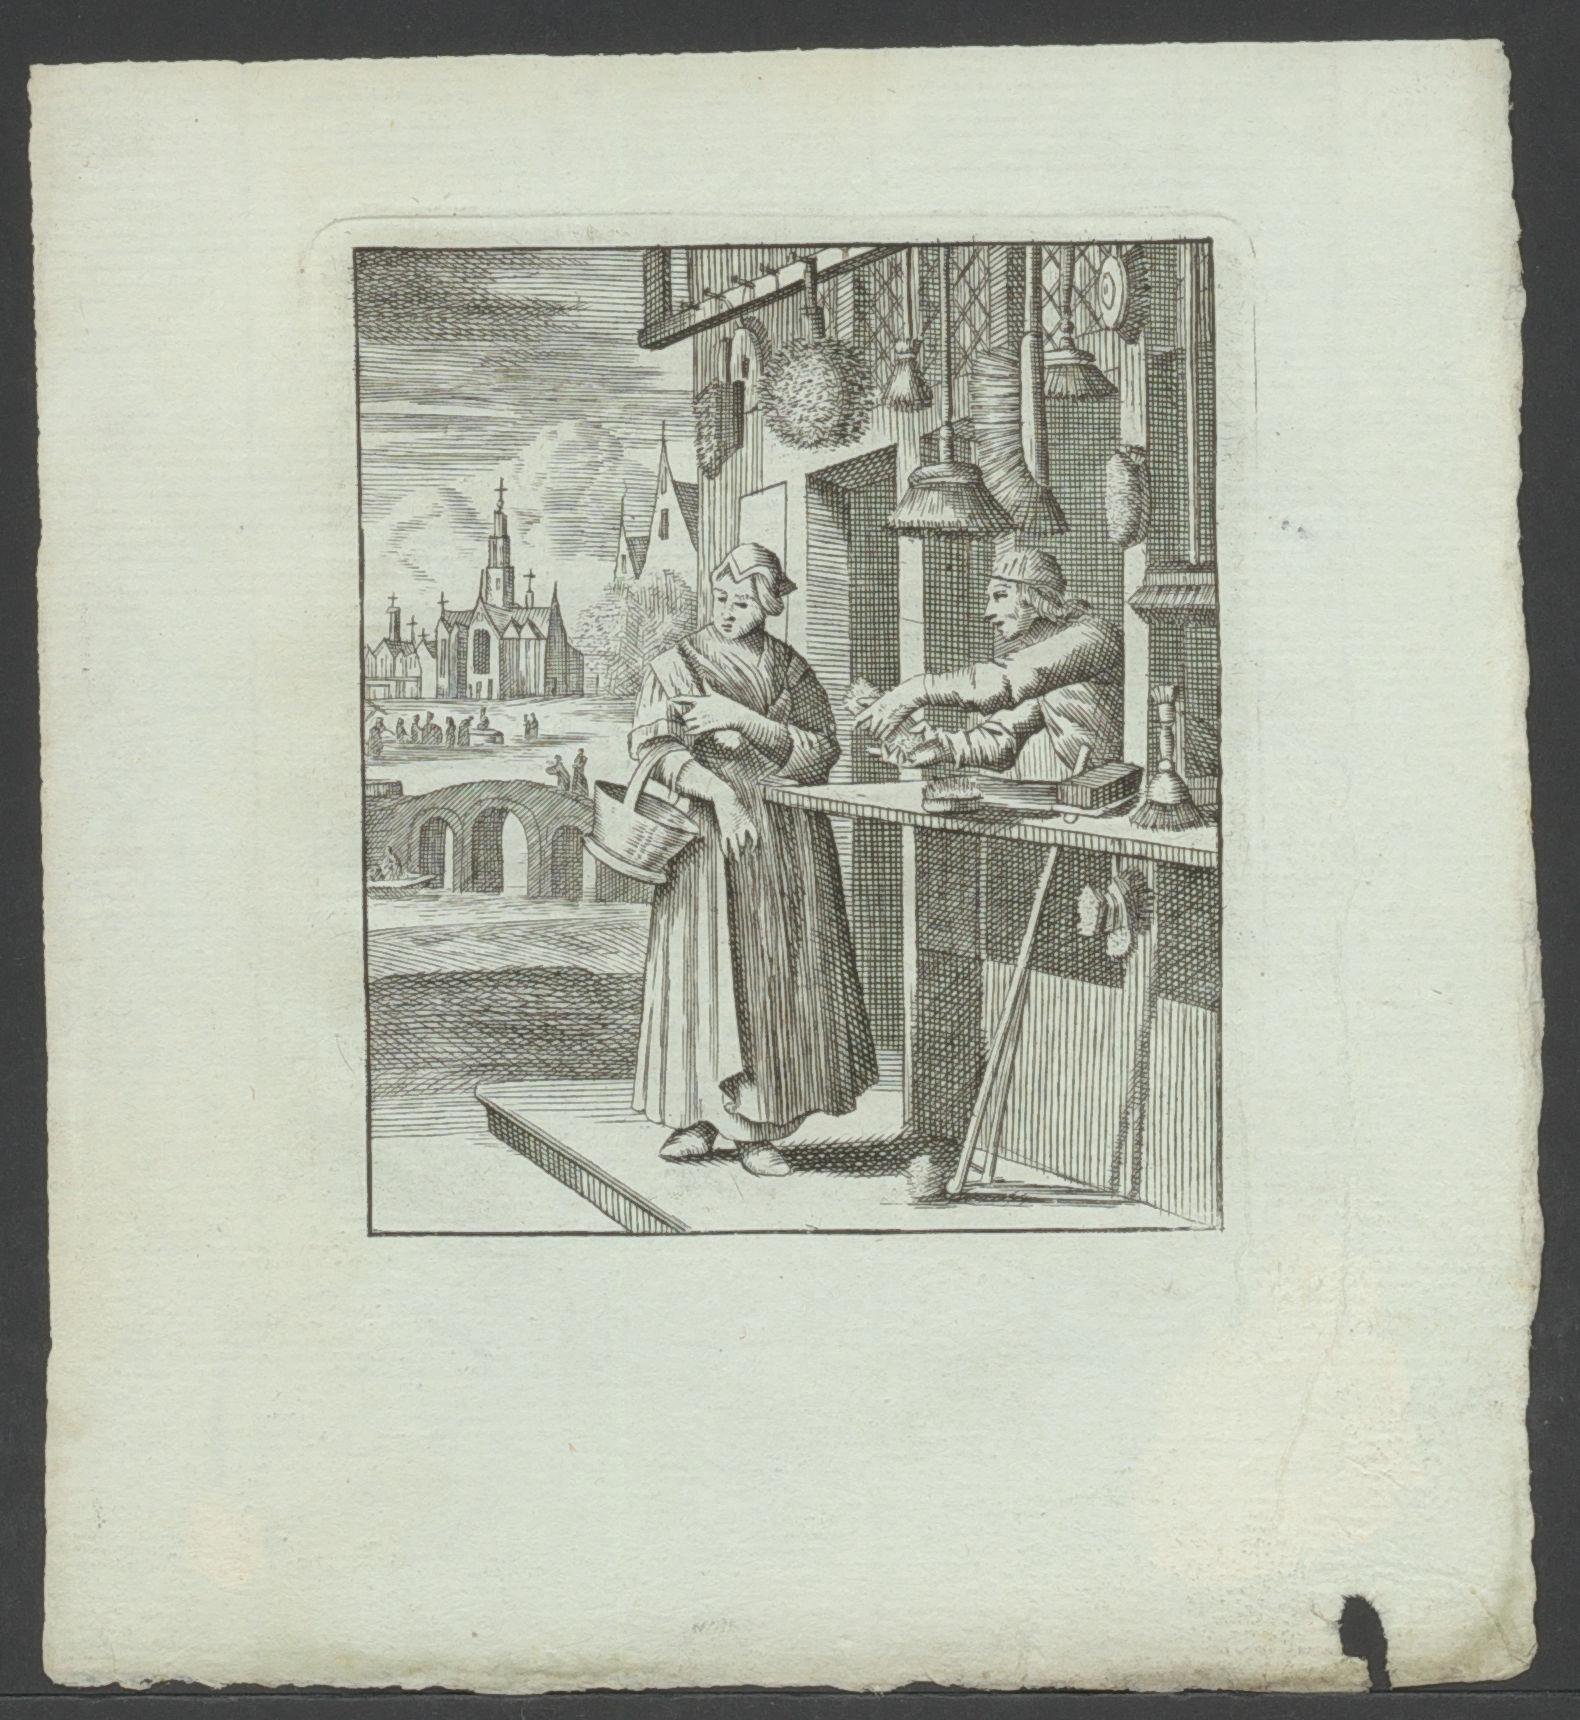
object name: print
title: Borstelmaker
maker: Anonymous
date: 1694-1799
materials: paper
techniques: engraving, etching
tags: dyeing of cloth, handicrafts, craftsman at work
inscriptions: collector's mark: Lugt 1641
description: Onderwerpsrubrieken binnen de Atlas Zeden en Gewoonten: Handel, Nijverheid en Verkeer, Beroep en bedrijf, Complete suites.